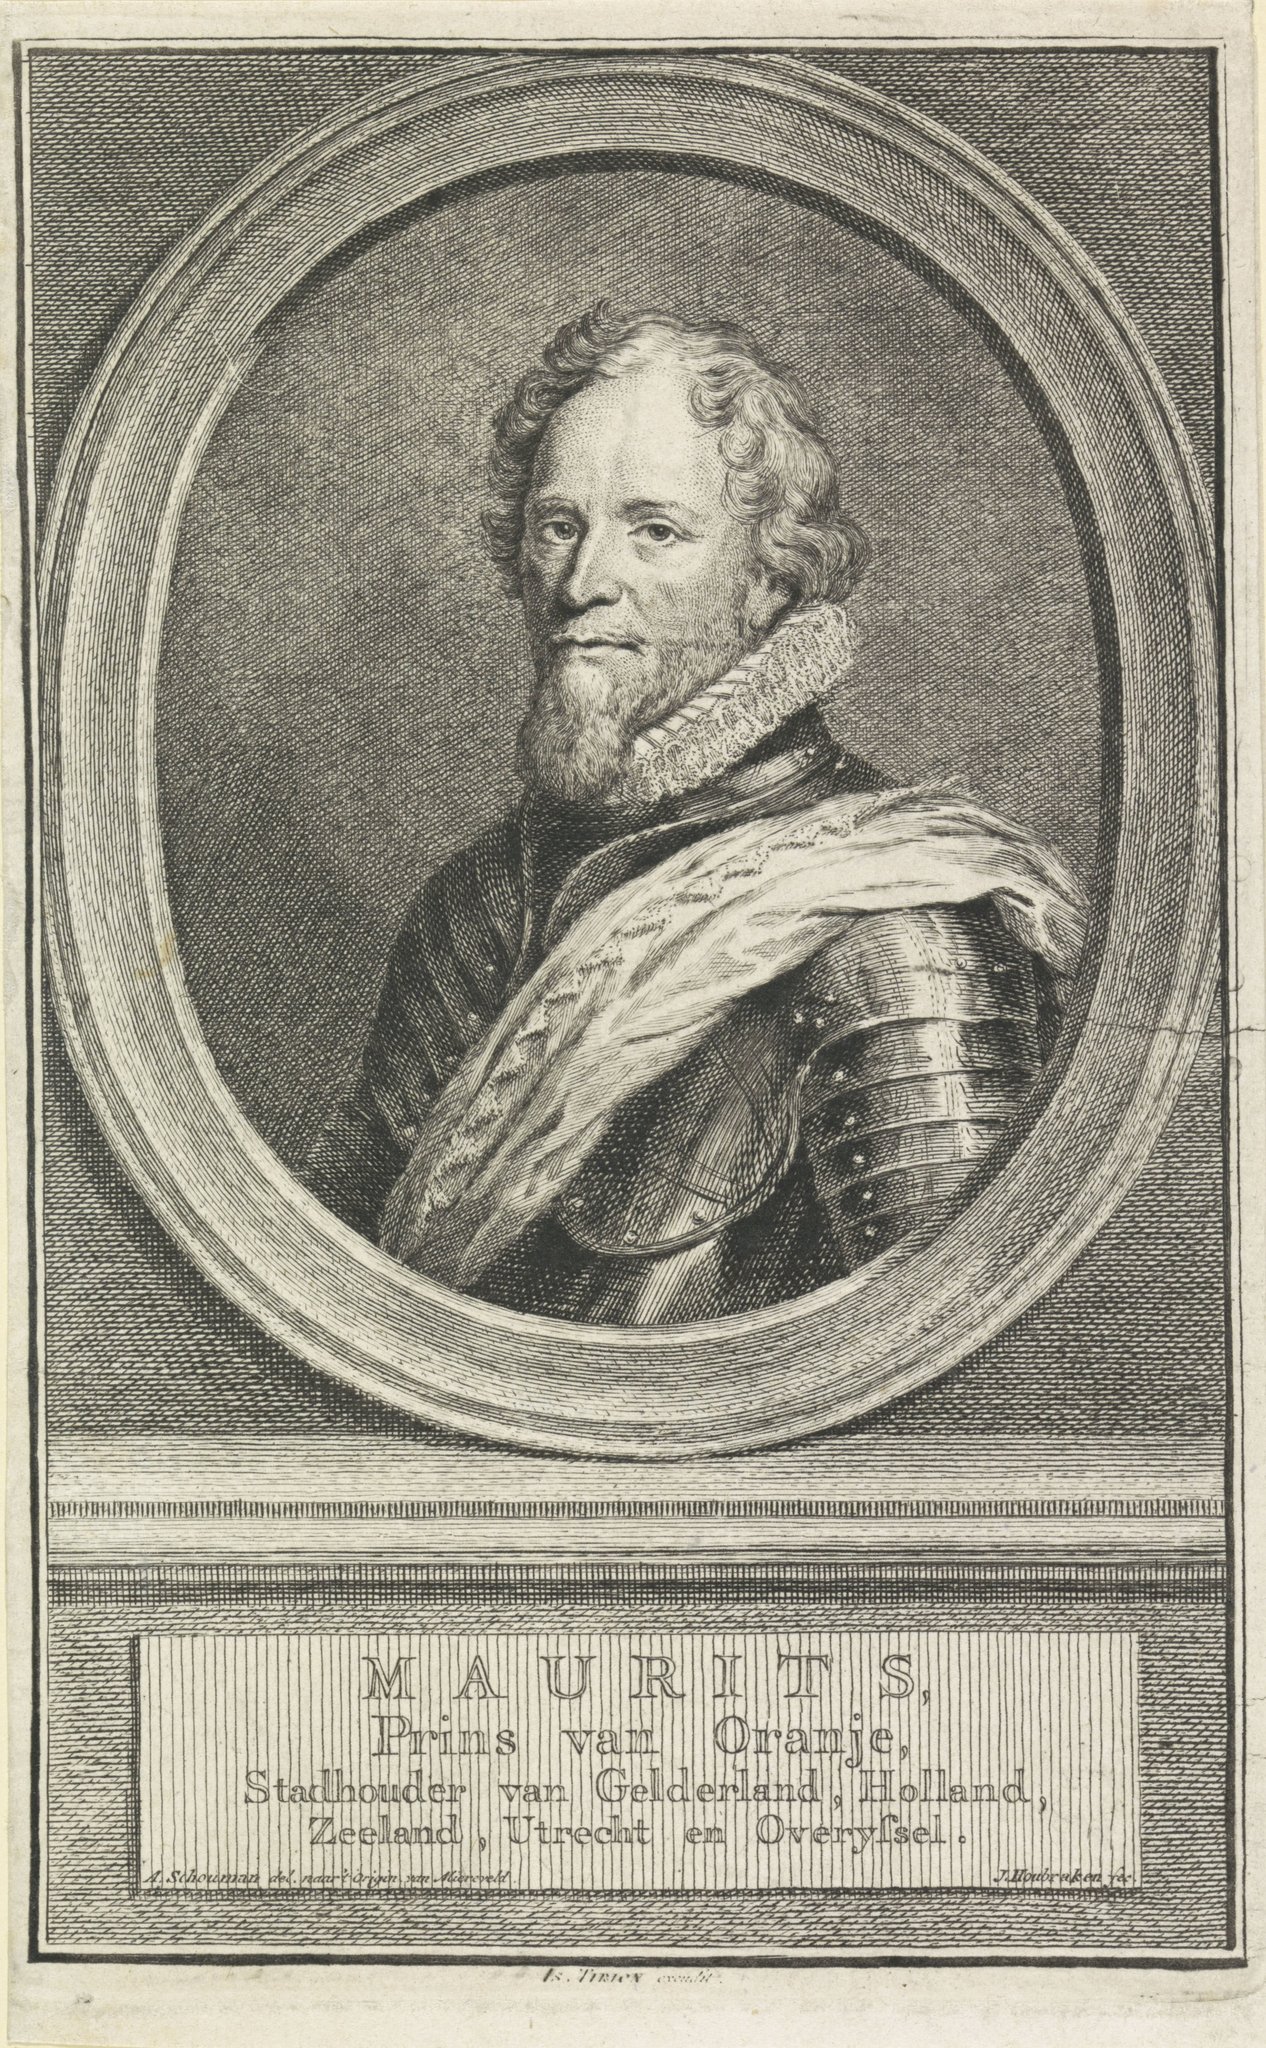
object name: print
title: Portret van Maurits, prins van Oranje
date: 1749-1759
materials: paper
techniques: engraving, etching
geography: amsterdam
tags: the hague, maurice (prince of orange)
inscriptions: collector's mark: Lugt 963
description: De hier vermelde titel verwijst naar de hoogst verkregen titel van de geportretteerde, niet per se naar de titel die de geportretteerde op deze voorstelling draagt. Prent uit: Wagenaar, Jan. Vaderlandsche historie. Amsterdam: Isaak Tirion, 1749-1759.